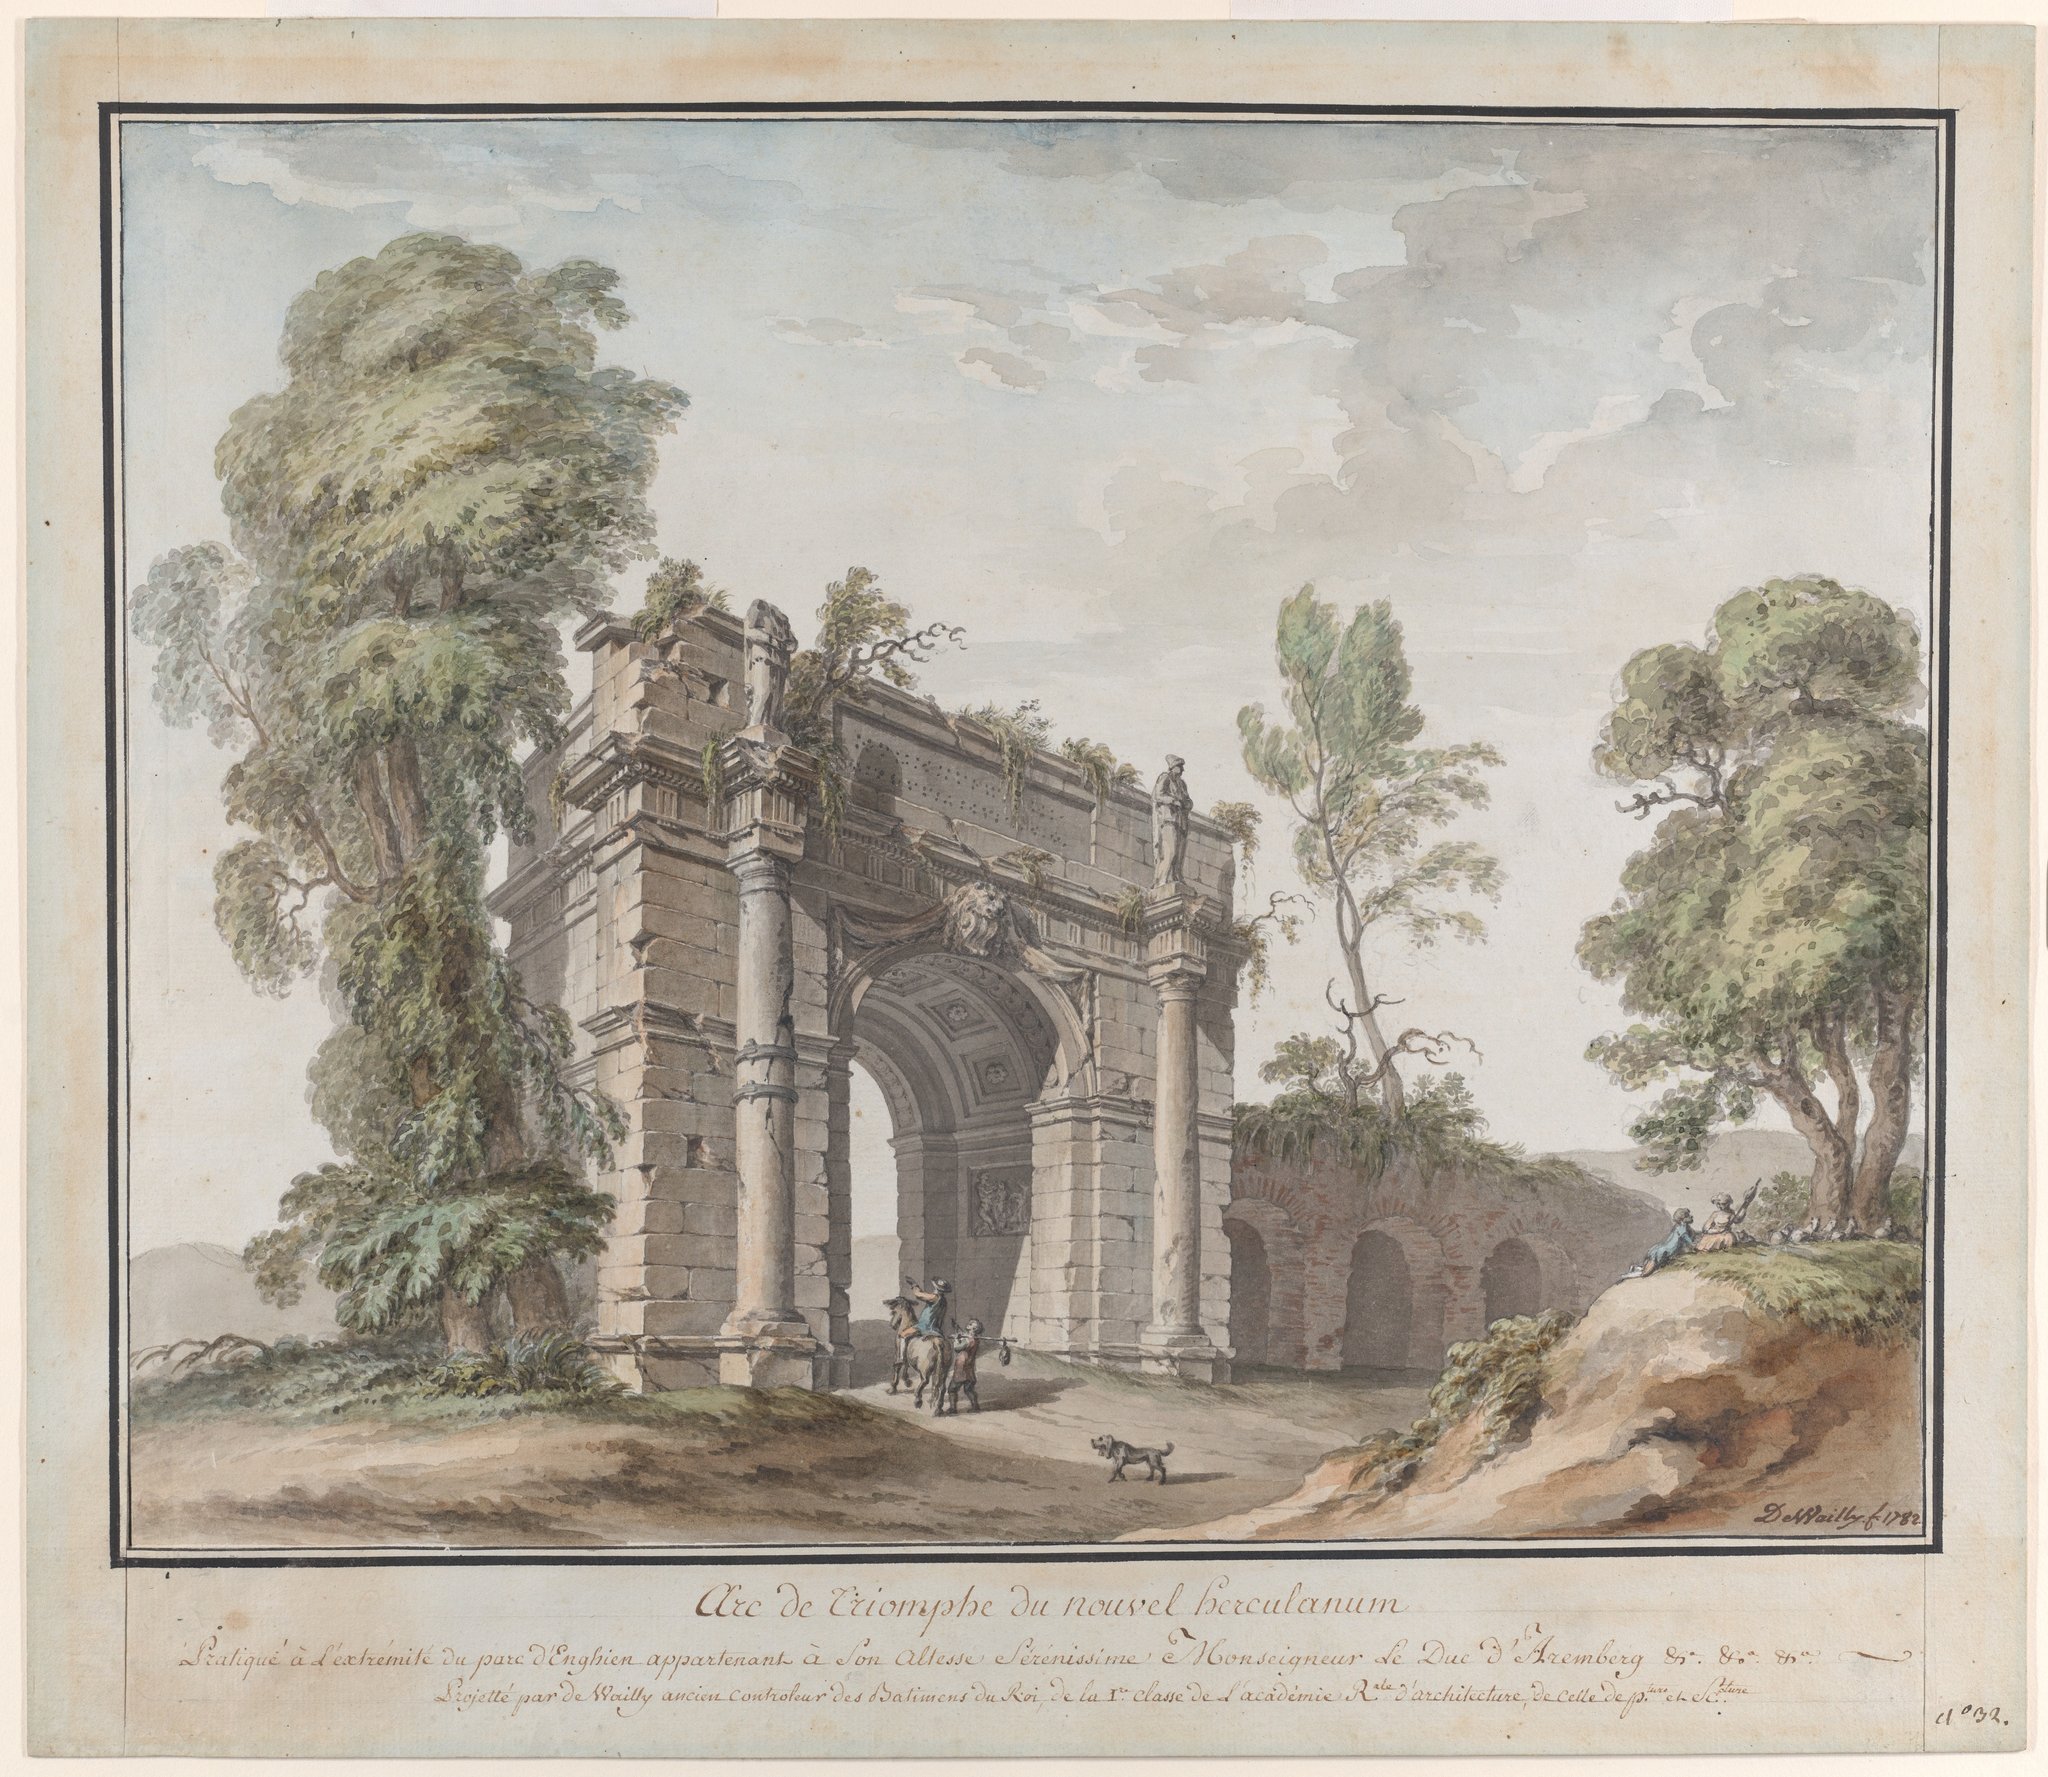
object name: drawing ornament architecture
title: Design for a Triumphal Arch for the Gardens at Chateau d'Enghien, Belgium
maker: charles de wailly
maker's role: artist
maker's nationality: french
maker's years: 1730-1798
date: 1782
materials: charcoal, ink, watercolor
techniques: pen, drawing